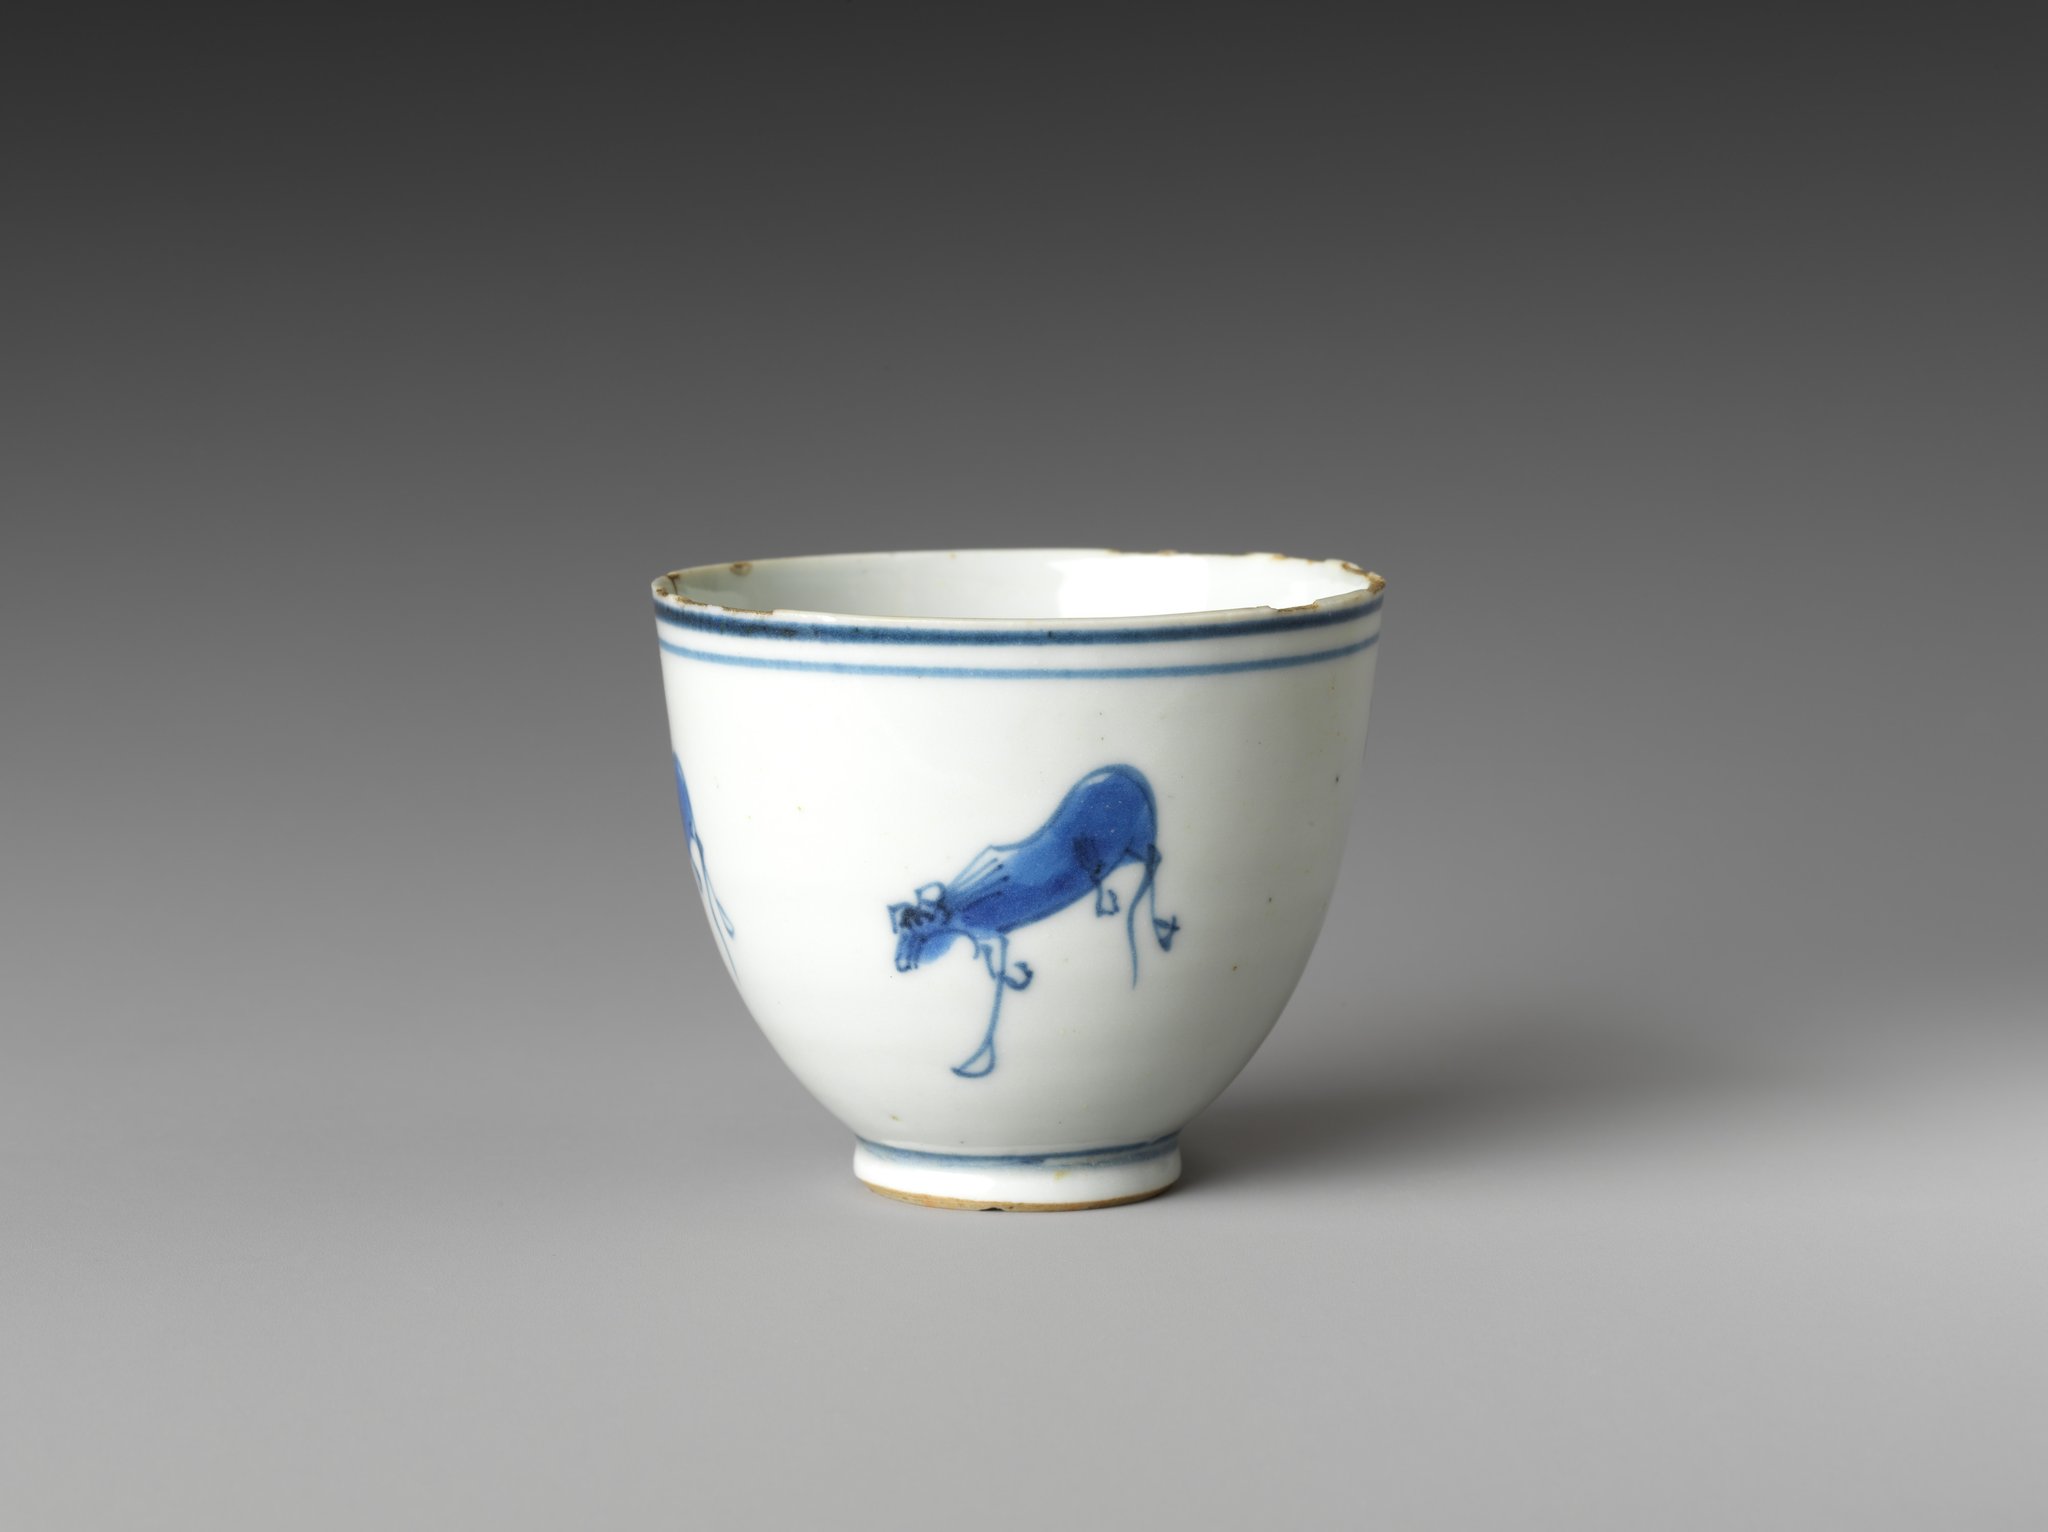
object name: cup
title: Cup with horses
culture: chinese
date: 1601-1633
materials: cobalt, porcelain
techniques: painting, underglaze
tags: horses